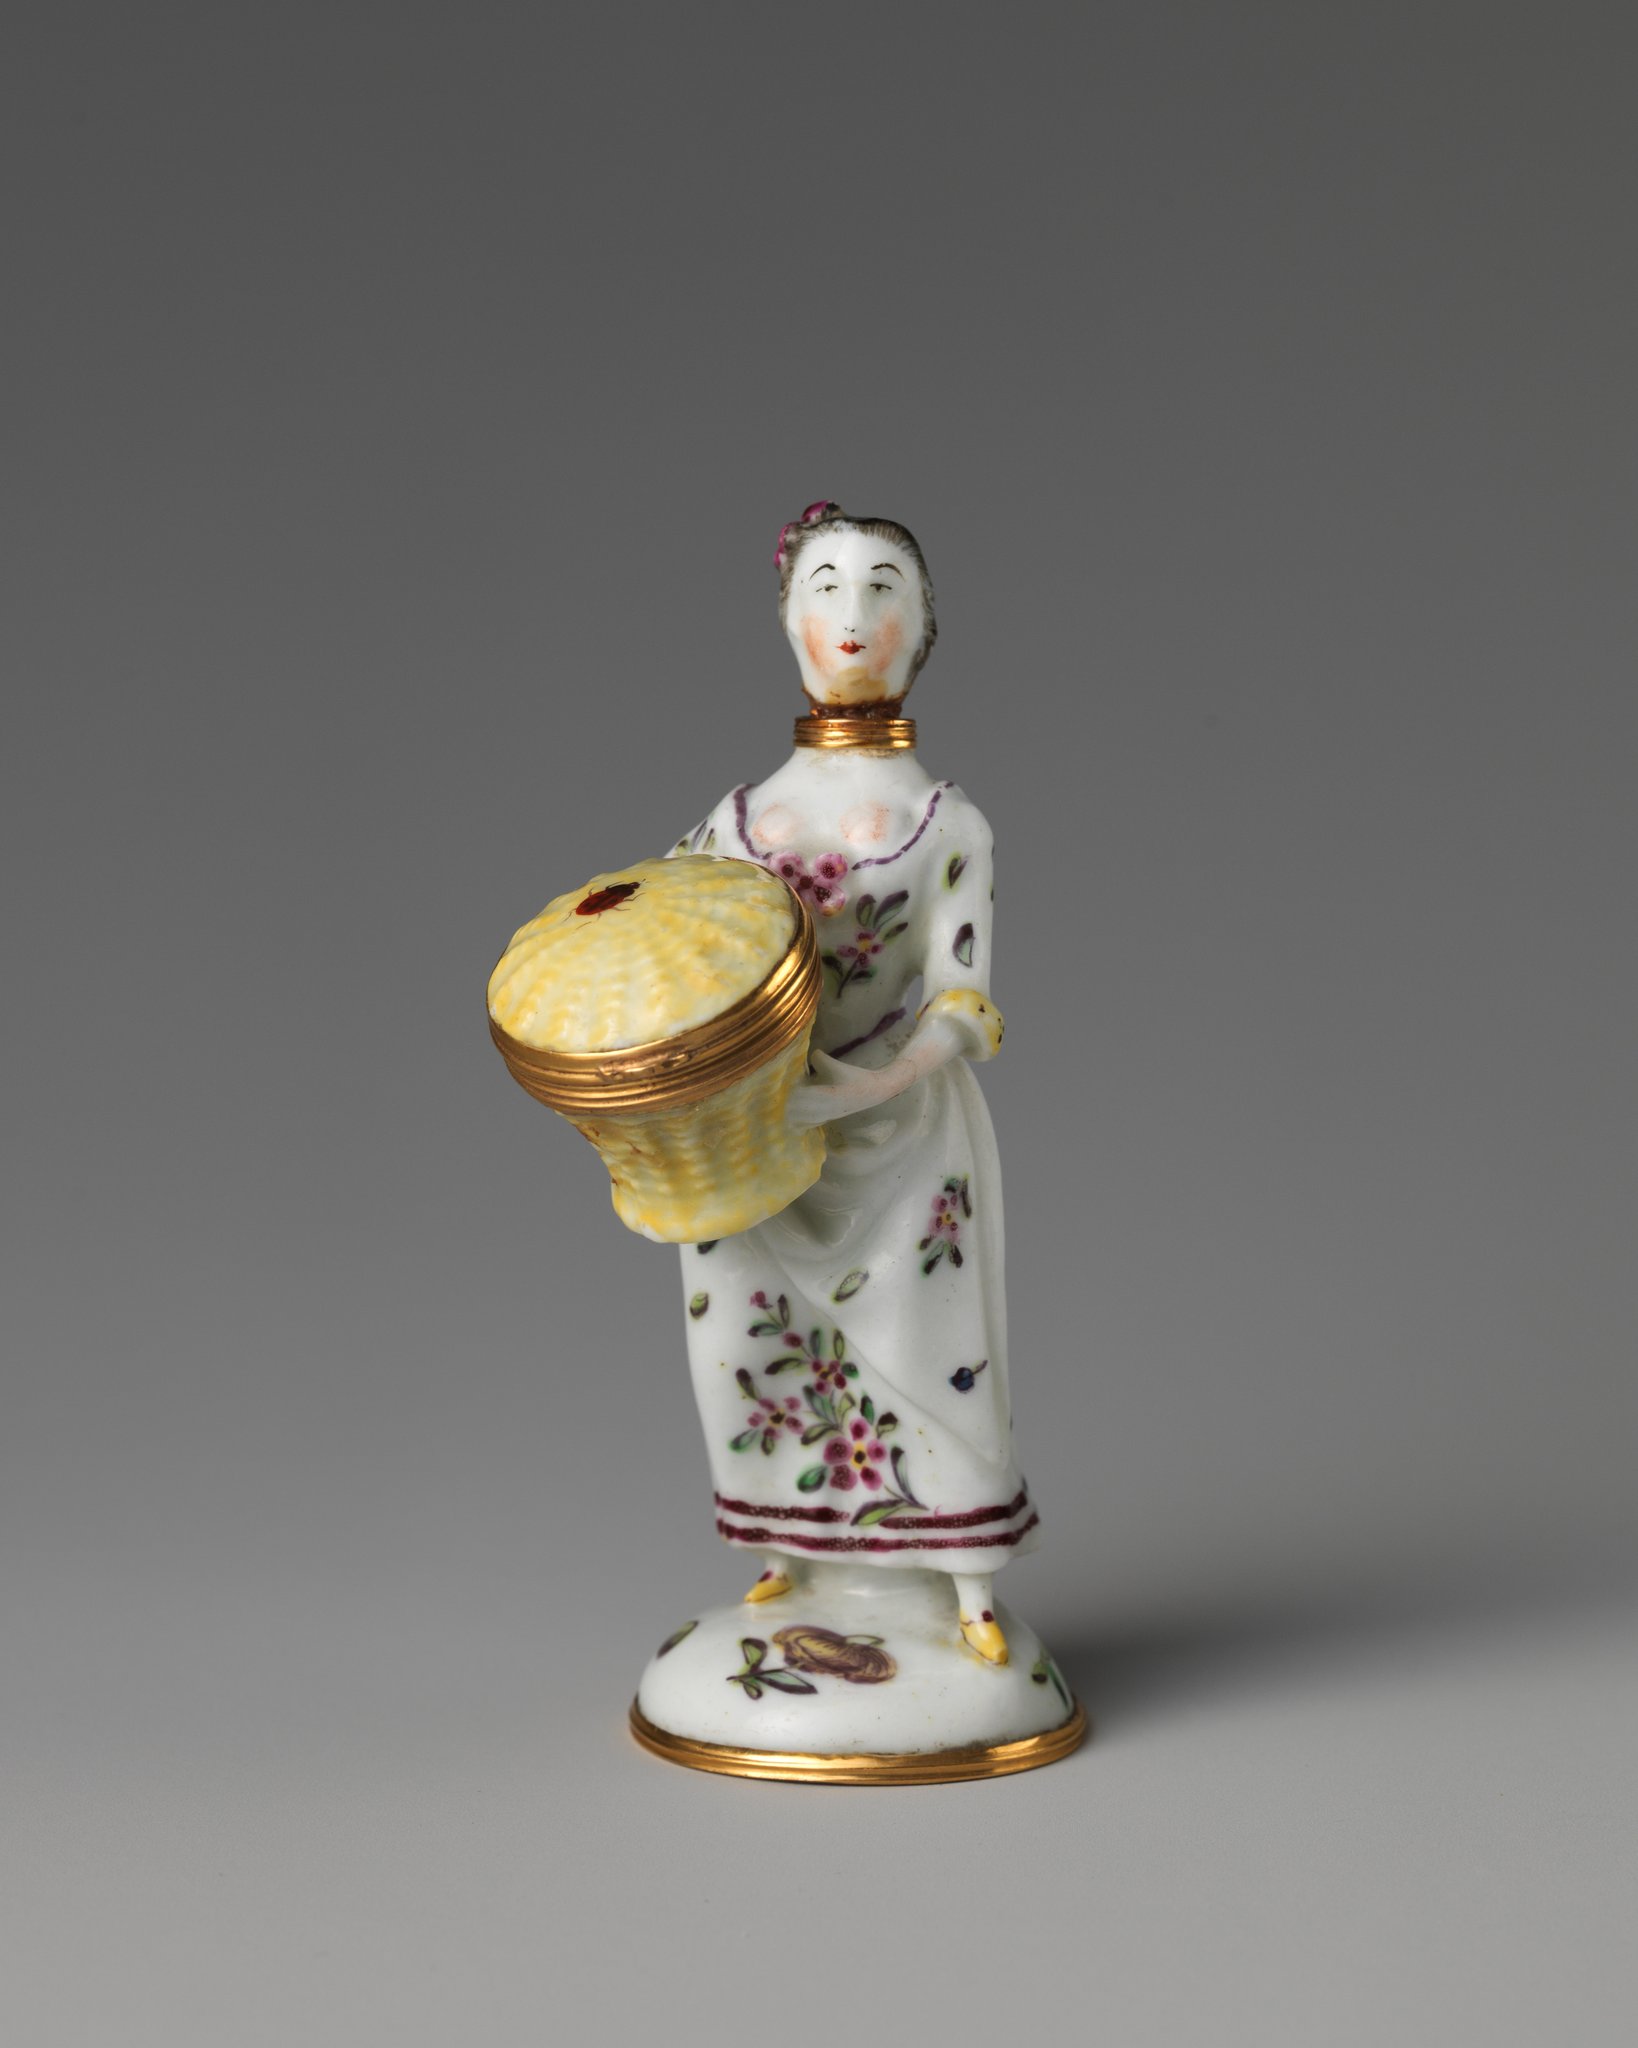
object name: toy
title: Lady with basket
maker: saint james's factory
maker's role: maker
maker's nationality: british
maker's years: 1749-1759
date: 1750-1755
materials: soft paste porcelain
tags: women